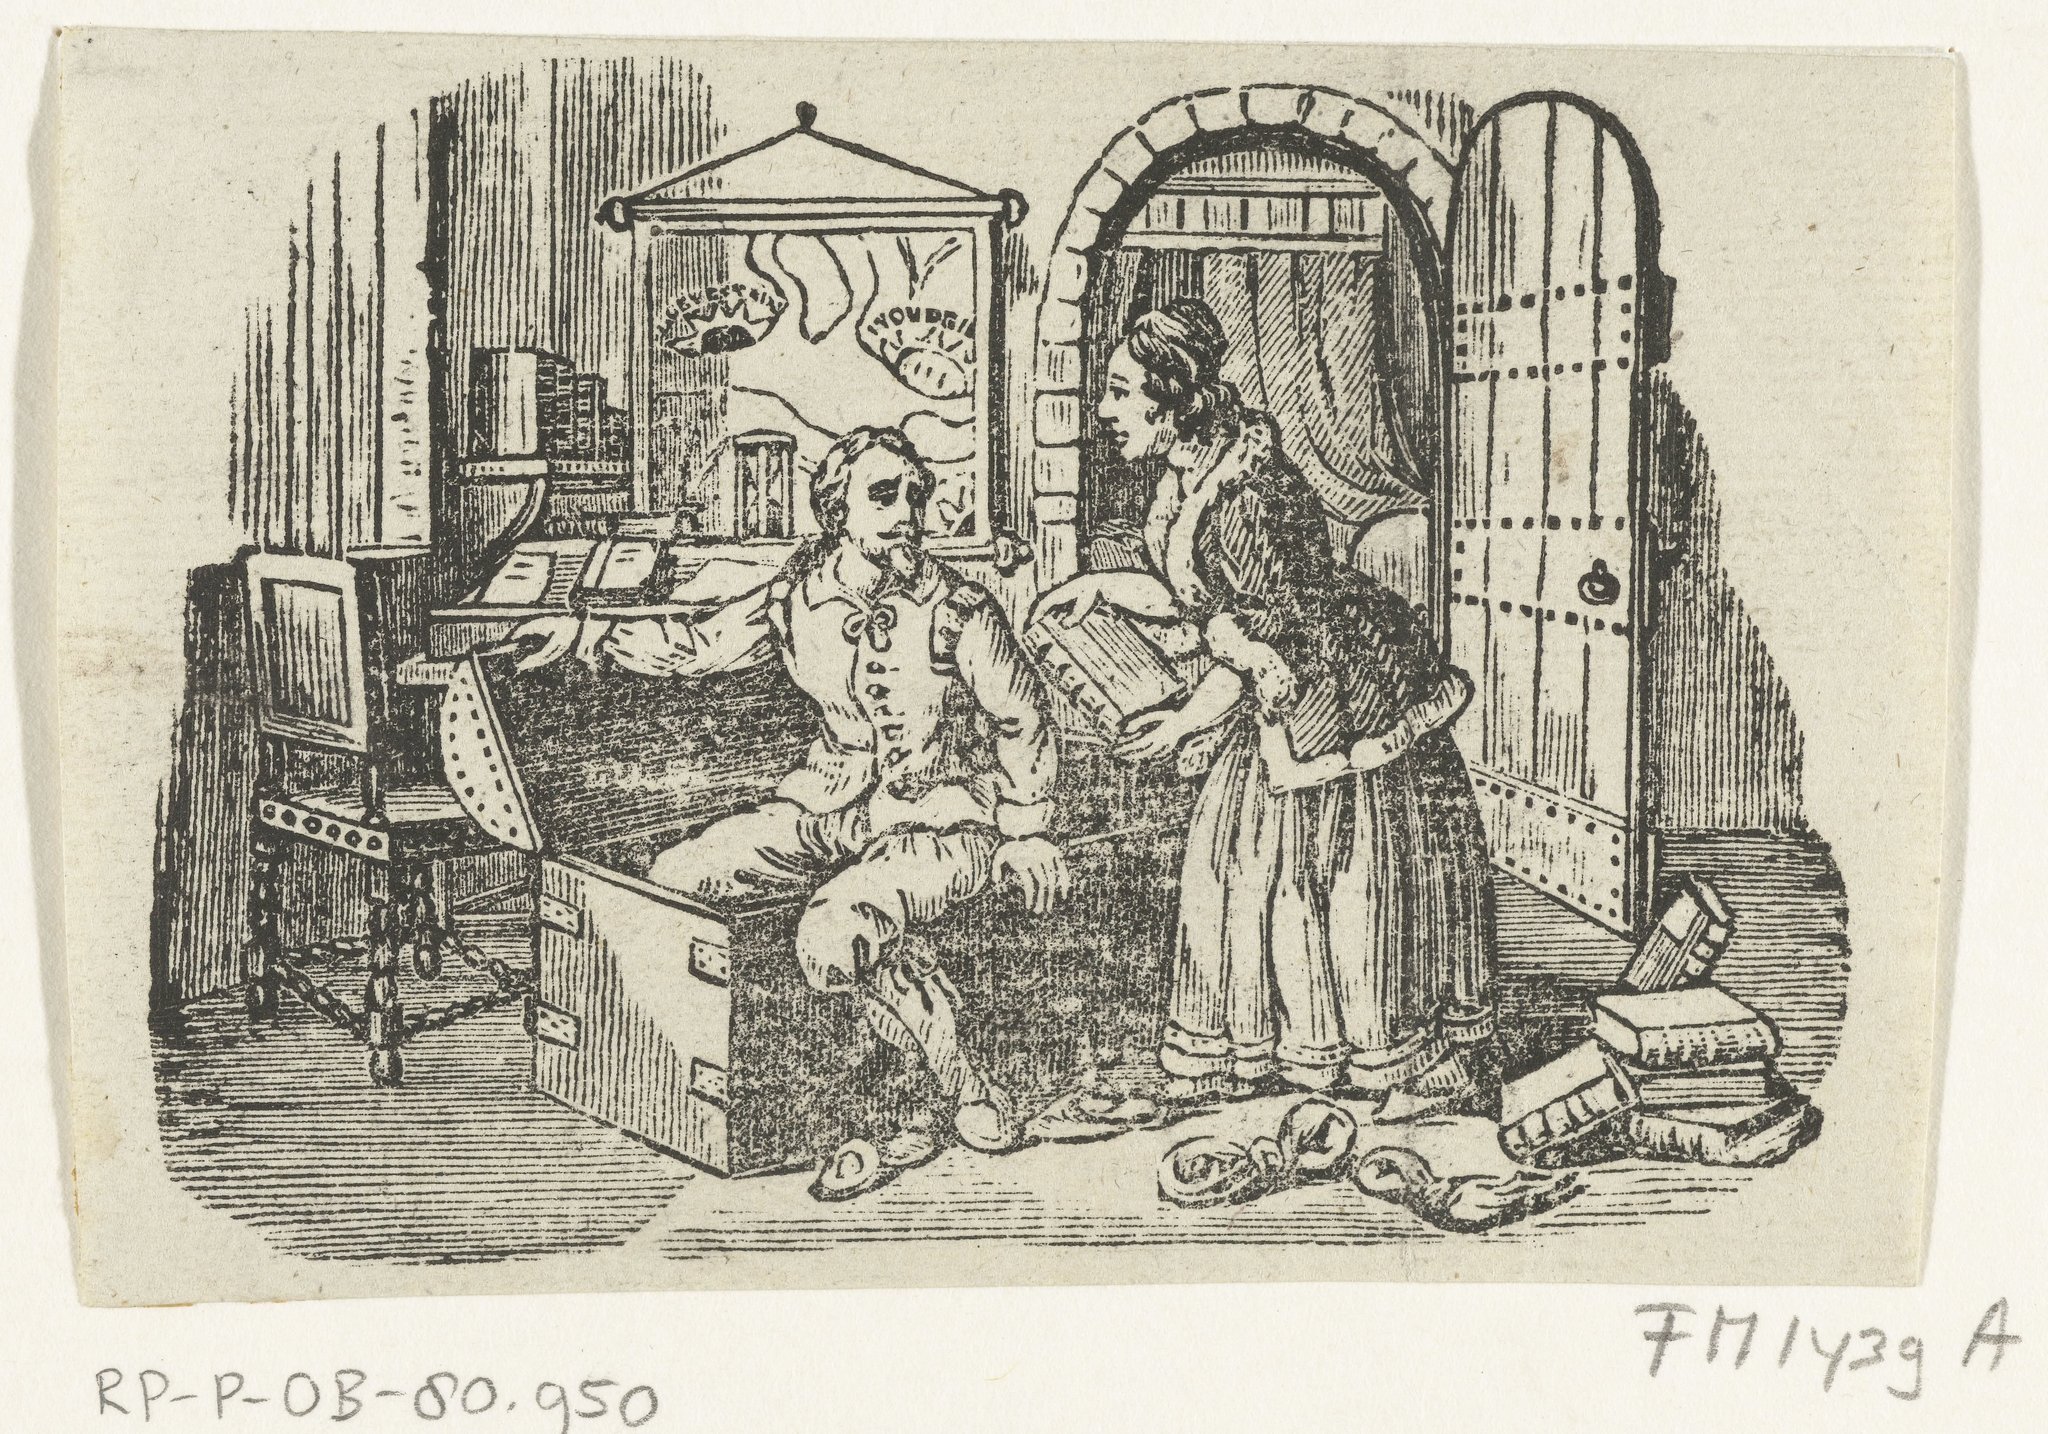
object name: history print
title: Hugo de Groot verstopt zich in de boekenkist, 1621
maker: Anonymous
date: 1800-1899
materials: paper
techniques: woodcut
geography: netherlands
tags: delft, hugo de groot, the hague, law and jurisprudence (+ escape from prison), loevestein castle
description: Hugo de Groot stapt in de boekenkist, 22 maart 1621. Zijn vrouw Maria van Reigersberch, die het plan voor de ontsnapping met de boekenkist had bedacht, staat naast hem met een boek in de handen.